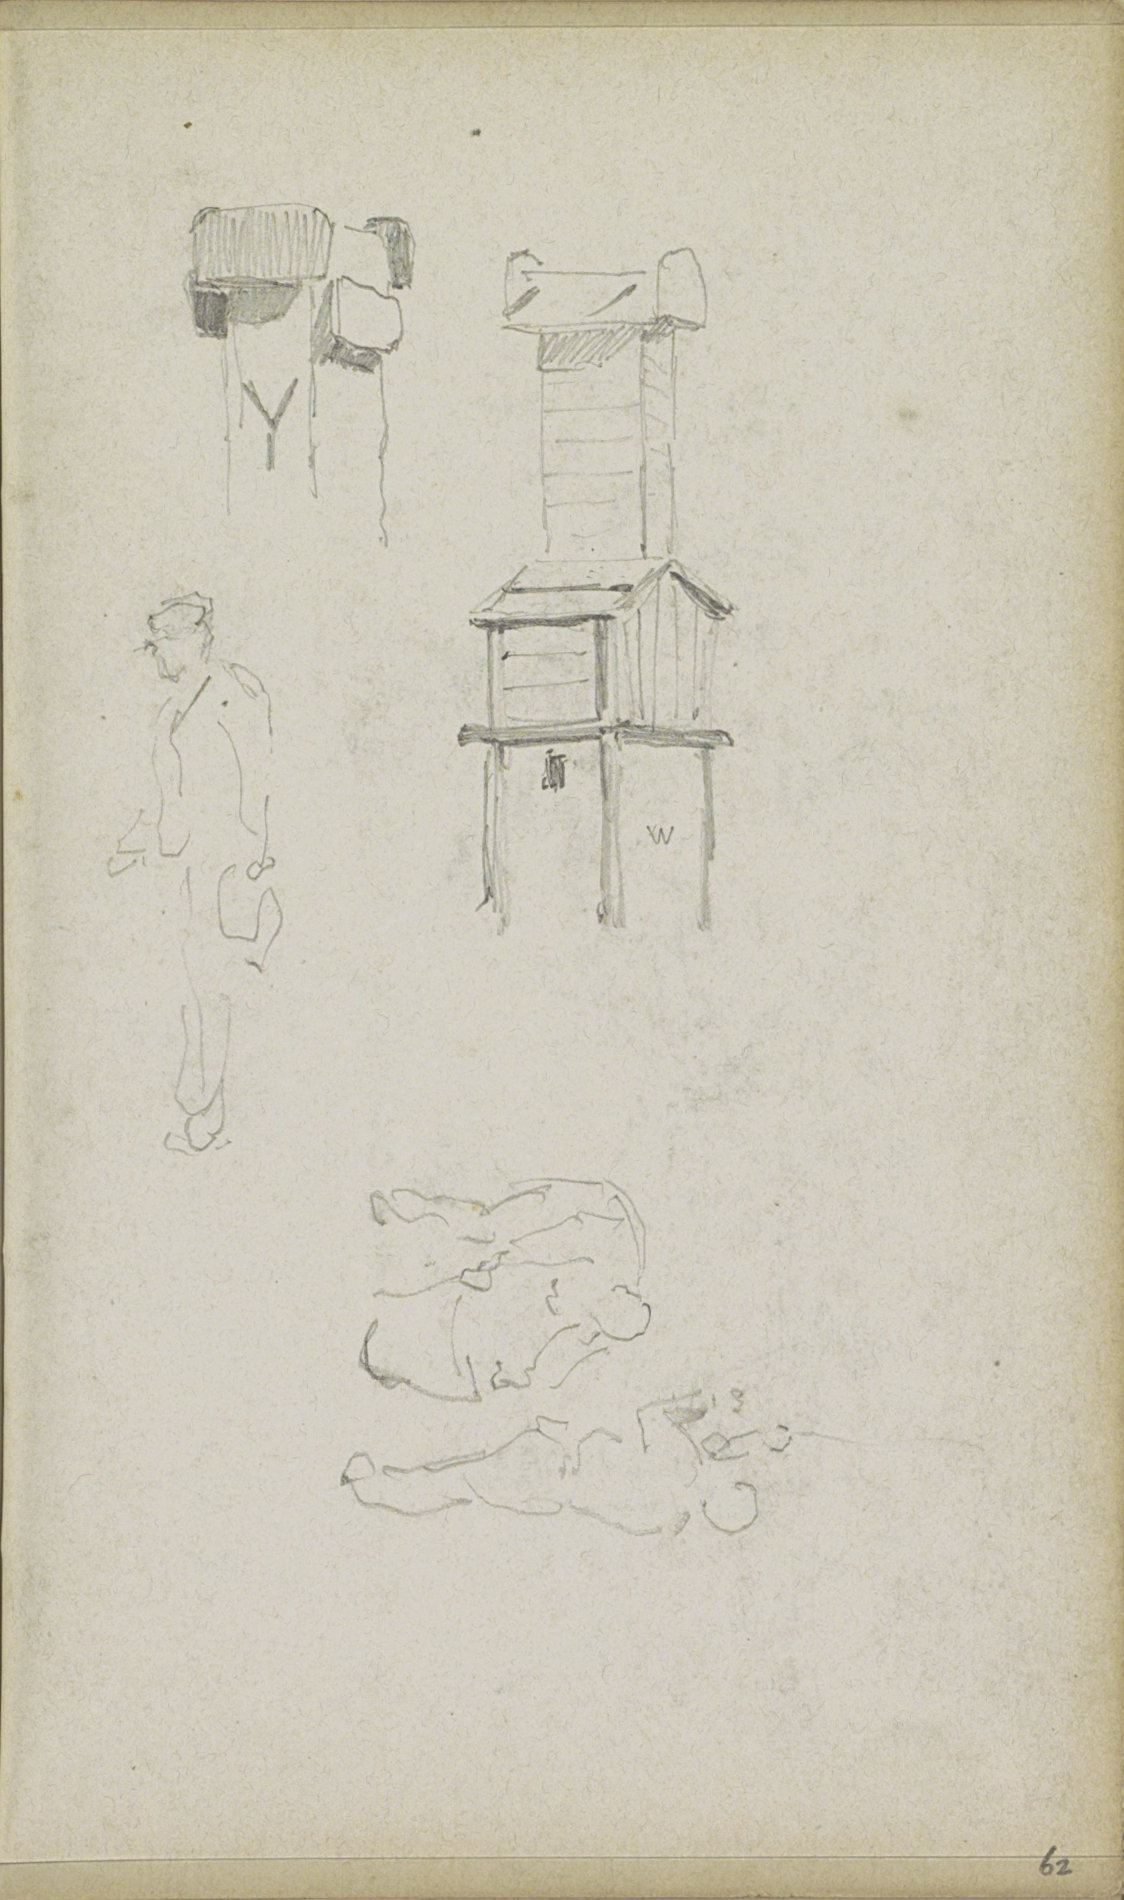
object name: sketchbook leaf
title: Architectuur- en figuurstudies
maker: adrianus eversen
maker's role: draughtsman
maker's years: 1818-1897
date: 1828-1897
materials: paper, pencil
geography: netherlands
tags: carrying something, architectural detail, adult man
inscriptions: kleurnotitie, handgeschreven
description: Boven twee architectuurstudies. Links een man met een pet. Onder een bukkende figuur met een mand of teil. Tegenover hem een figuur met een voorwerp of een kind in zijn handen. Blad 62 recto uit een schetsboek met 69 bladen vervaardigd in de omgeving van Delft, Rotterdam, Oudewater en Harlingen.